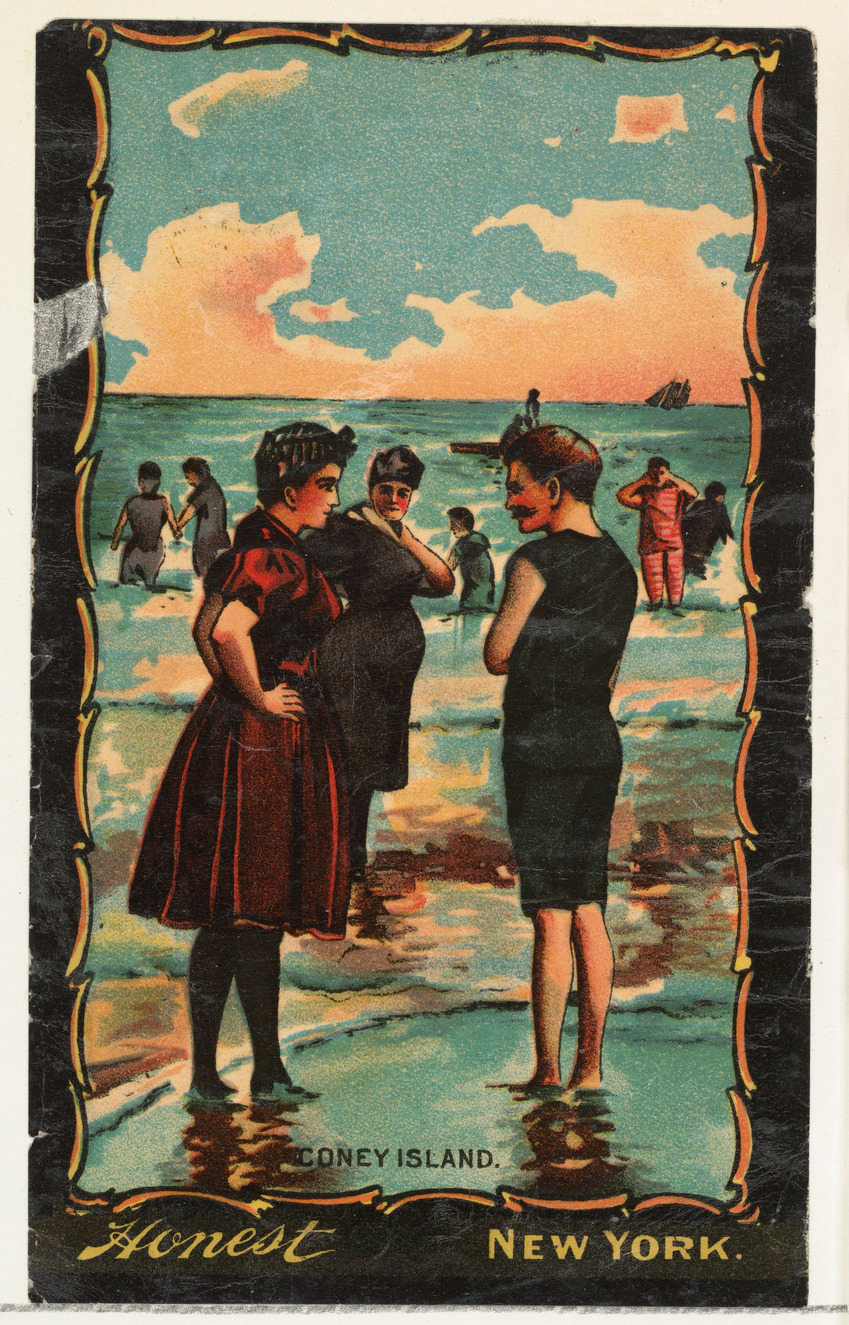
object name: print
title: Coney Island, from the Transparencies series (N137) issued by W. Duke, Sons & Co. to promote Honest Long Cut Tobacco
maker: w. duke, sons & co.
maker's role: publisher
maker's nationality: american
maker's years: 1870-1920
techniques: color lithograph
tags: men,women,beaches